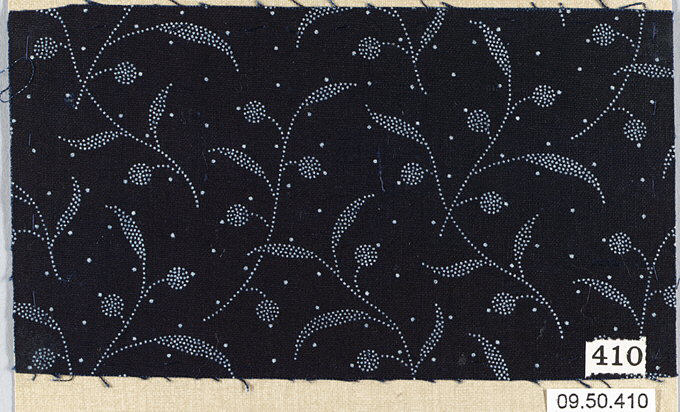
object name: piece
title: Piece (one of 116)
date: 1801-1900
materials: cotton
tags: leaves